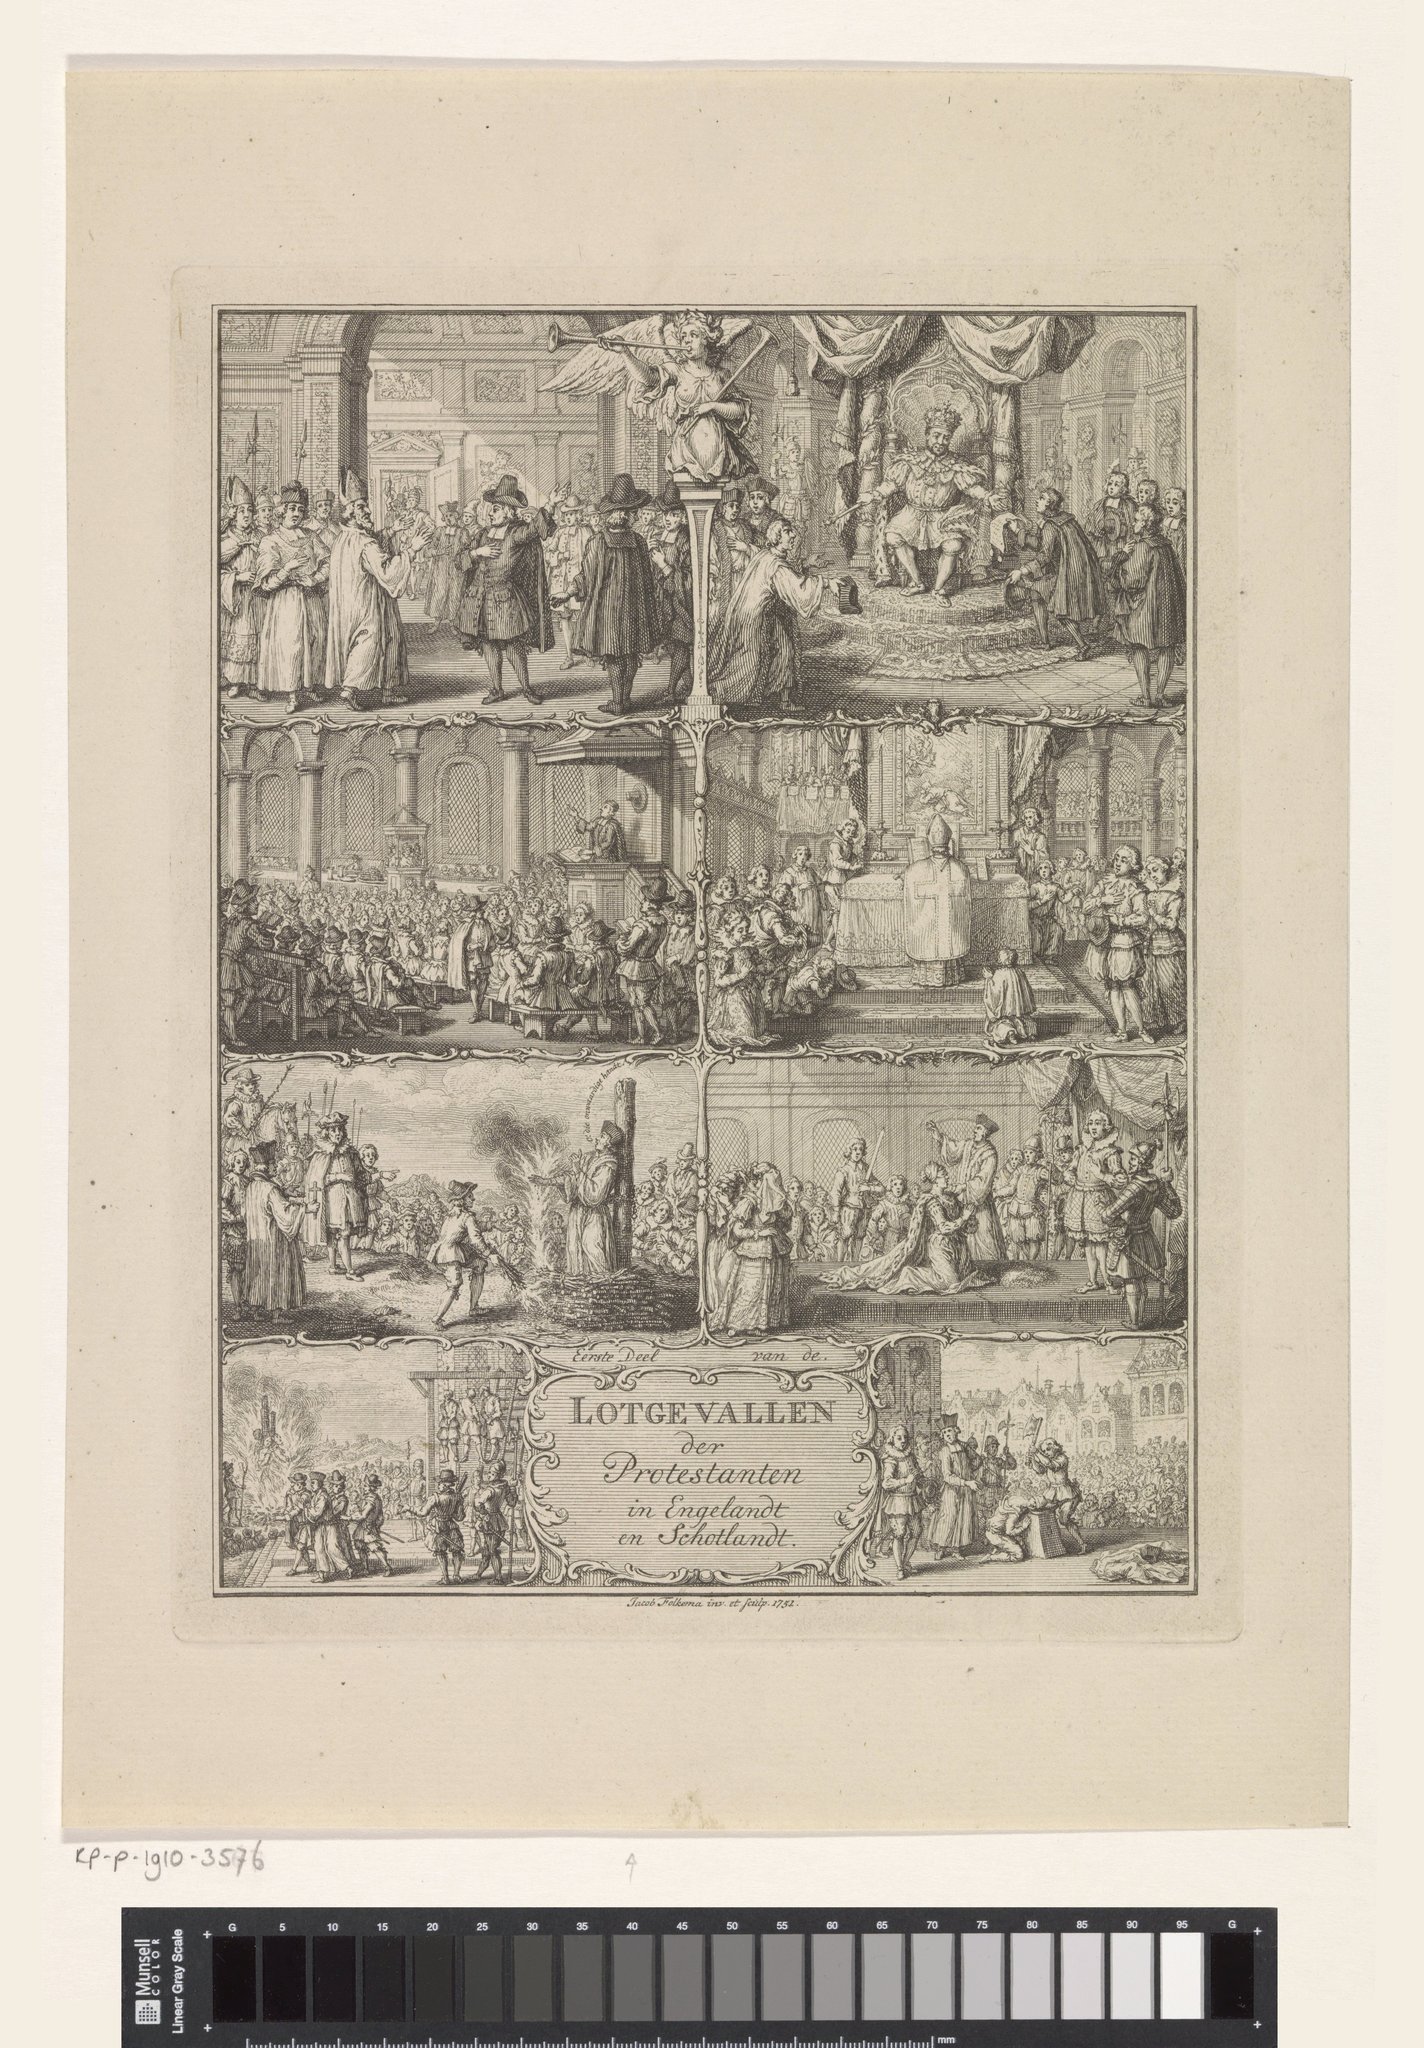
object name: print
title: Acht historische scènes met lotgevallen van Protestanten in Engeland en Schotland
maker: jacob folkema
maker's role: draughtsman, print maker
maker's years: 1692-1767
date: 1751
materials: paper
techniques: etching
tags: historical events and situations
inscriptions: collector's mark: Lugt 2228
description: Acht voorstellingen met scènes uit de Schotse en Engelse geschiedenis waarin de historie van de Protestanten centraal staat. De scènes staan per twee boven elkaar afgebeeld en worden door sierlijke lijsten van elkaar gescheiden. Middenboven prijkt een bazuin blazende engel.